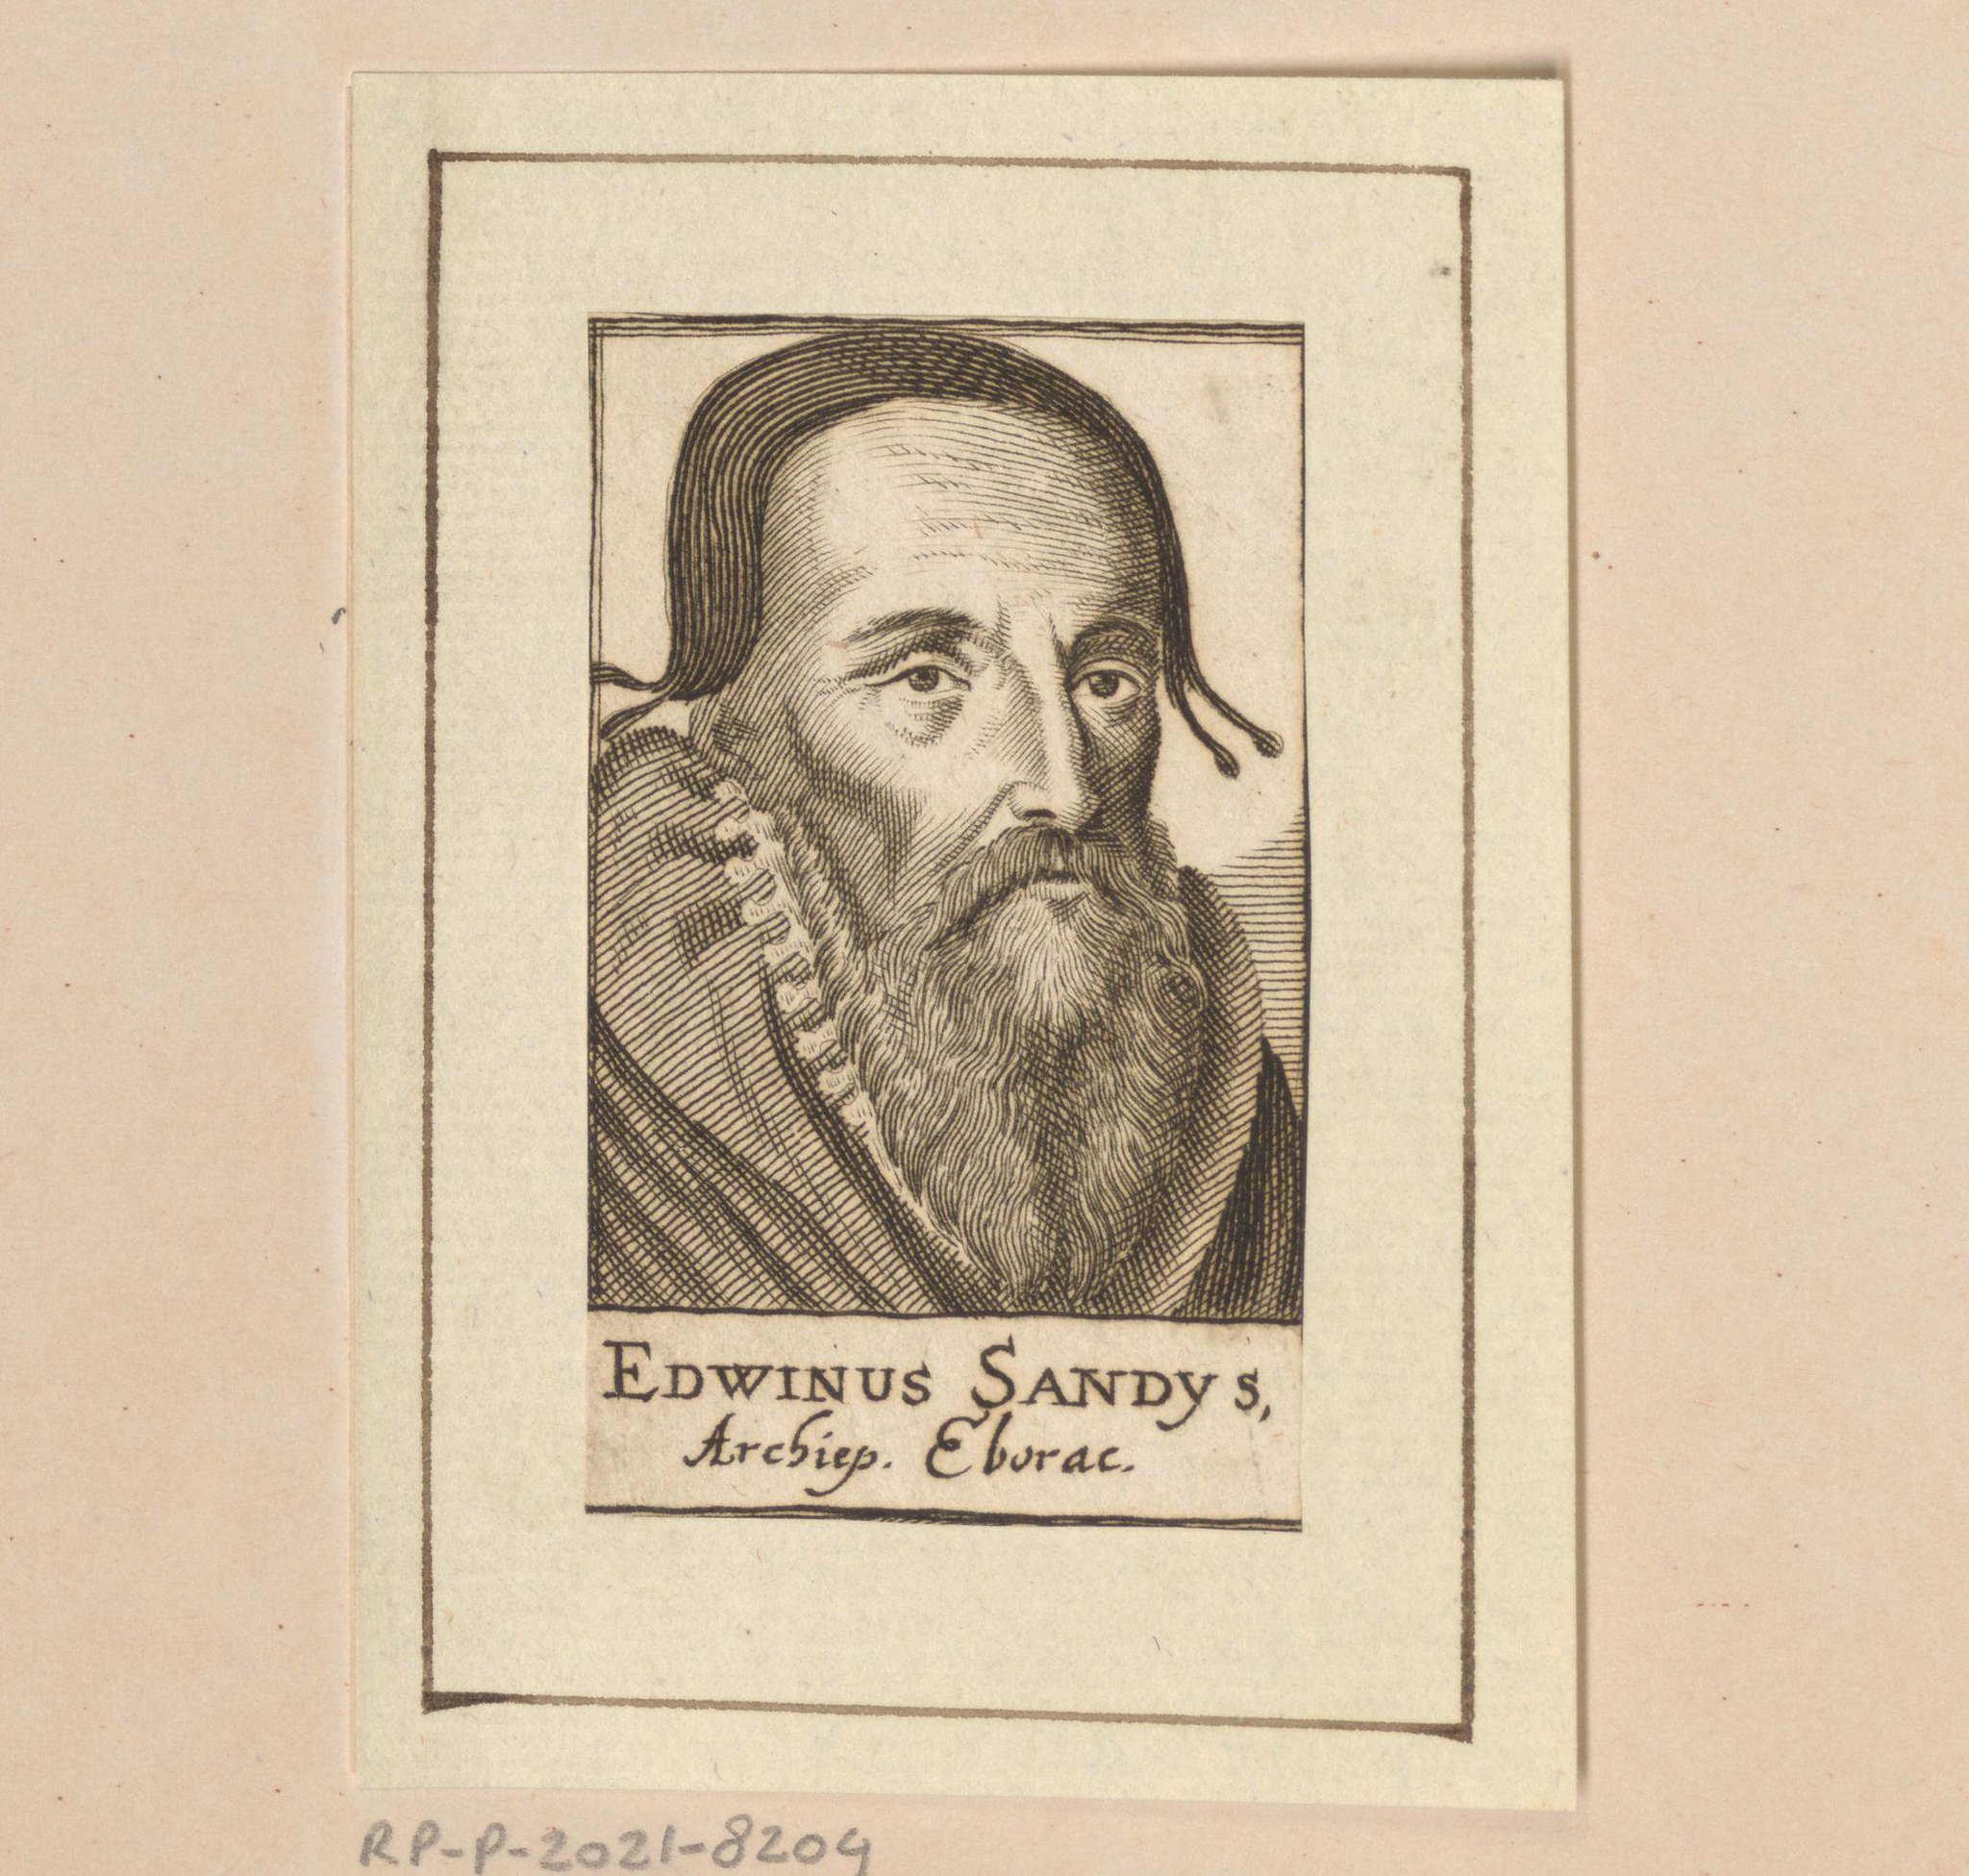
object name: print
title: Portret van Edwin Sandys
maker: Anonymous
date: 1688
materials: paper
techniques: engraving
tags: archbishop, bishop, etc. (roman catholic), historical persons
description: Prent maakt deel uit van een grotere prent die later is verknipt. Prent waarschijnlijk uit: Freher, Paul. Theatrum virorum eruditione clarorum. Neurenberg: Johann Hoffmann, 1688.